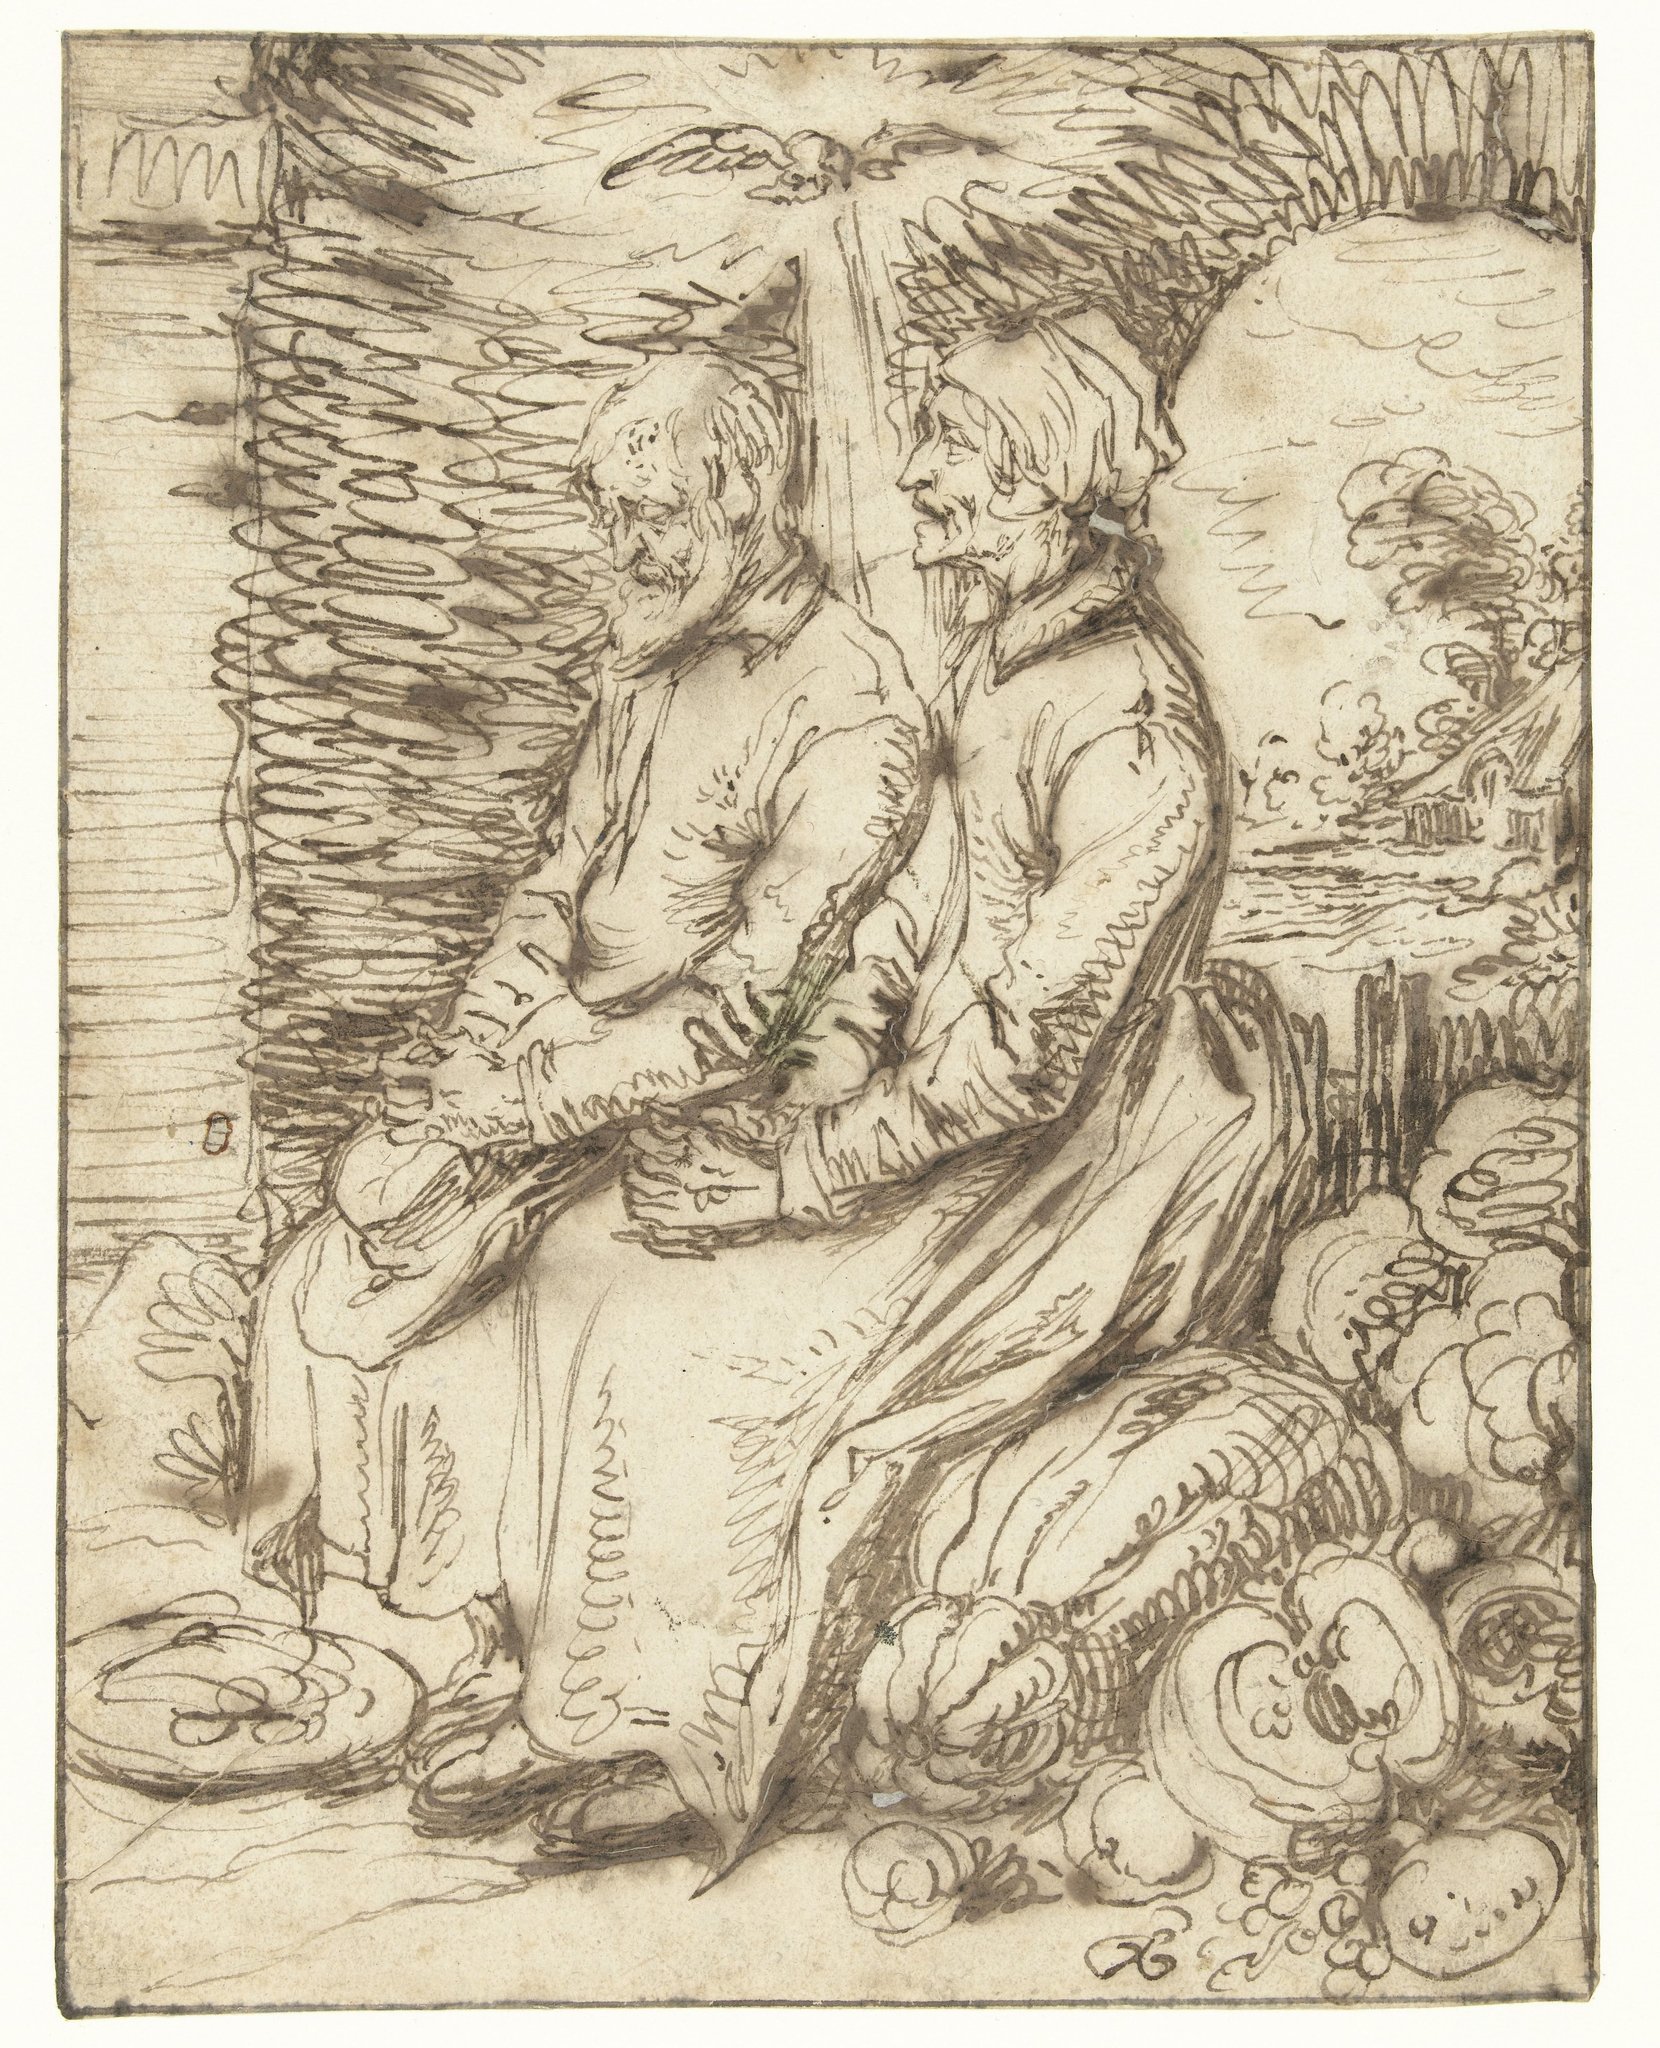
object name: drawing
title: Vreedsamich Paer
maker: jacques de gheyn (ii)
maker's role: painter, print maker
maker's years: 1565-1629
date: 1605-1615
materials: ink, paper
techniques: pen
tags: (personifications of) 'vanitas', the vanity of human life; fragilità humana, fugacità delle grandezze & della gloria mondana, meditatione della morte, opera vana, piacere vano, vana gloria, vanità (ripa), hands folded with fingers knit, old age, 'senectus'; 'vecchiezza' (ripa), holy ghost represented as a dove (in flames)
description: Een oude boer en zijn vrouw diep in gebed zittend voor de vruchten van hun noeste arbeid. Boven hen zweeft de duif van de Heilige Geest. Rechts een poort, een boerderij. Ontwerp voor een prent.